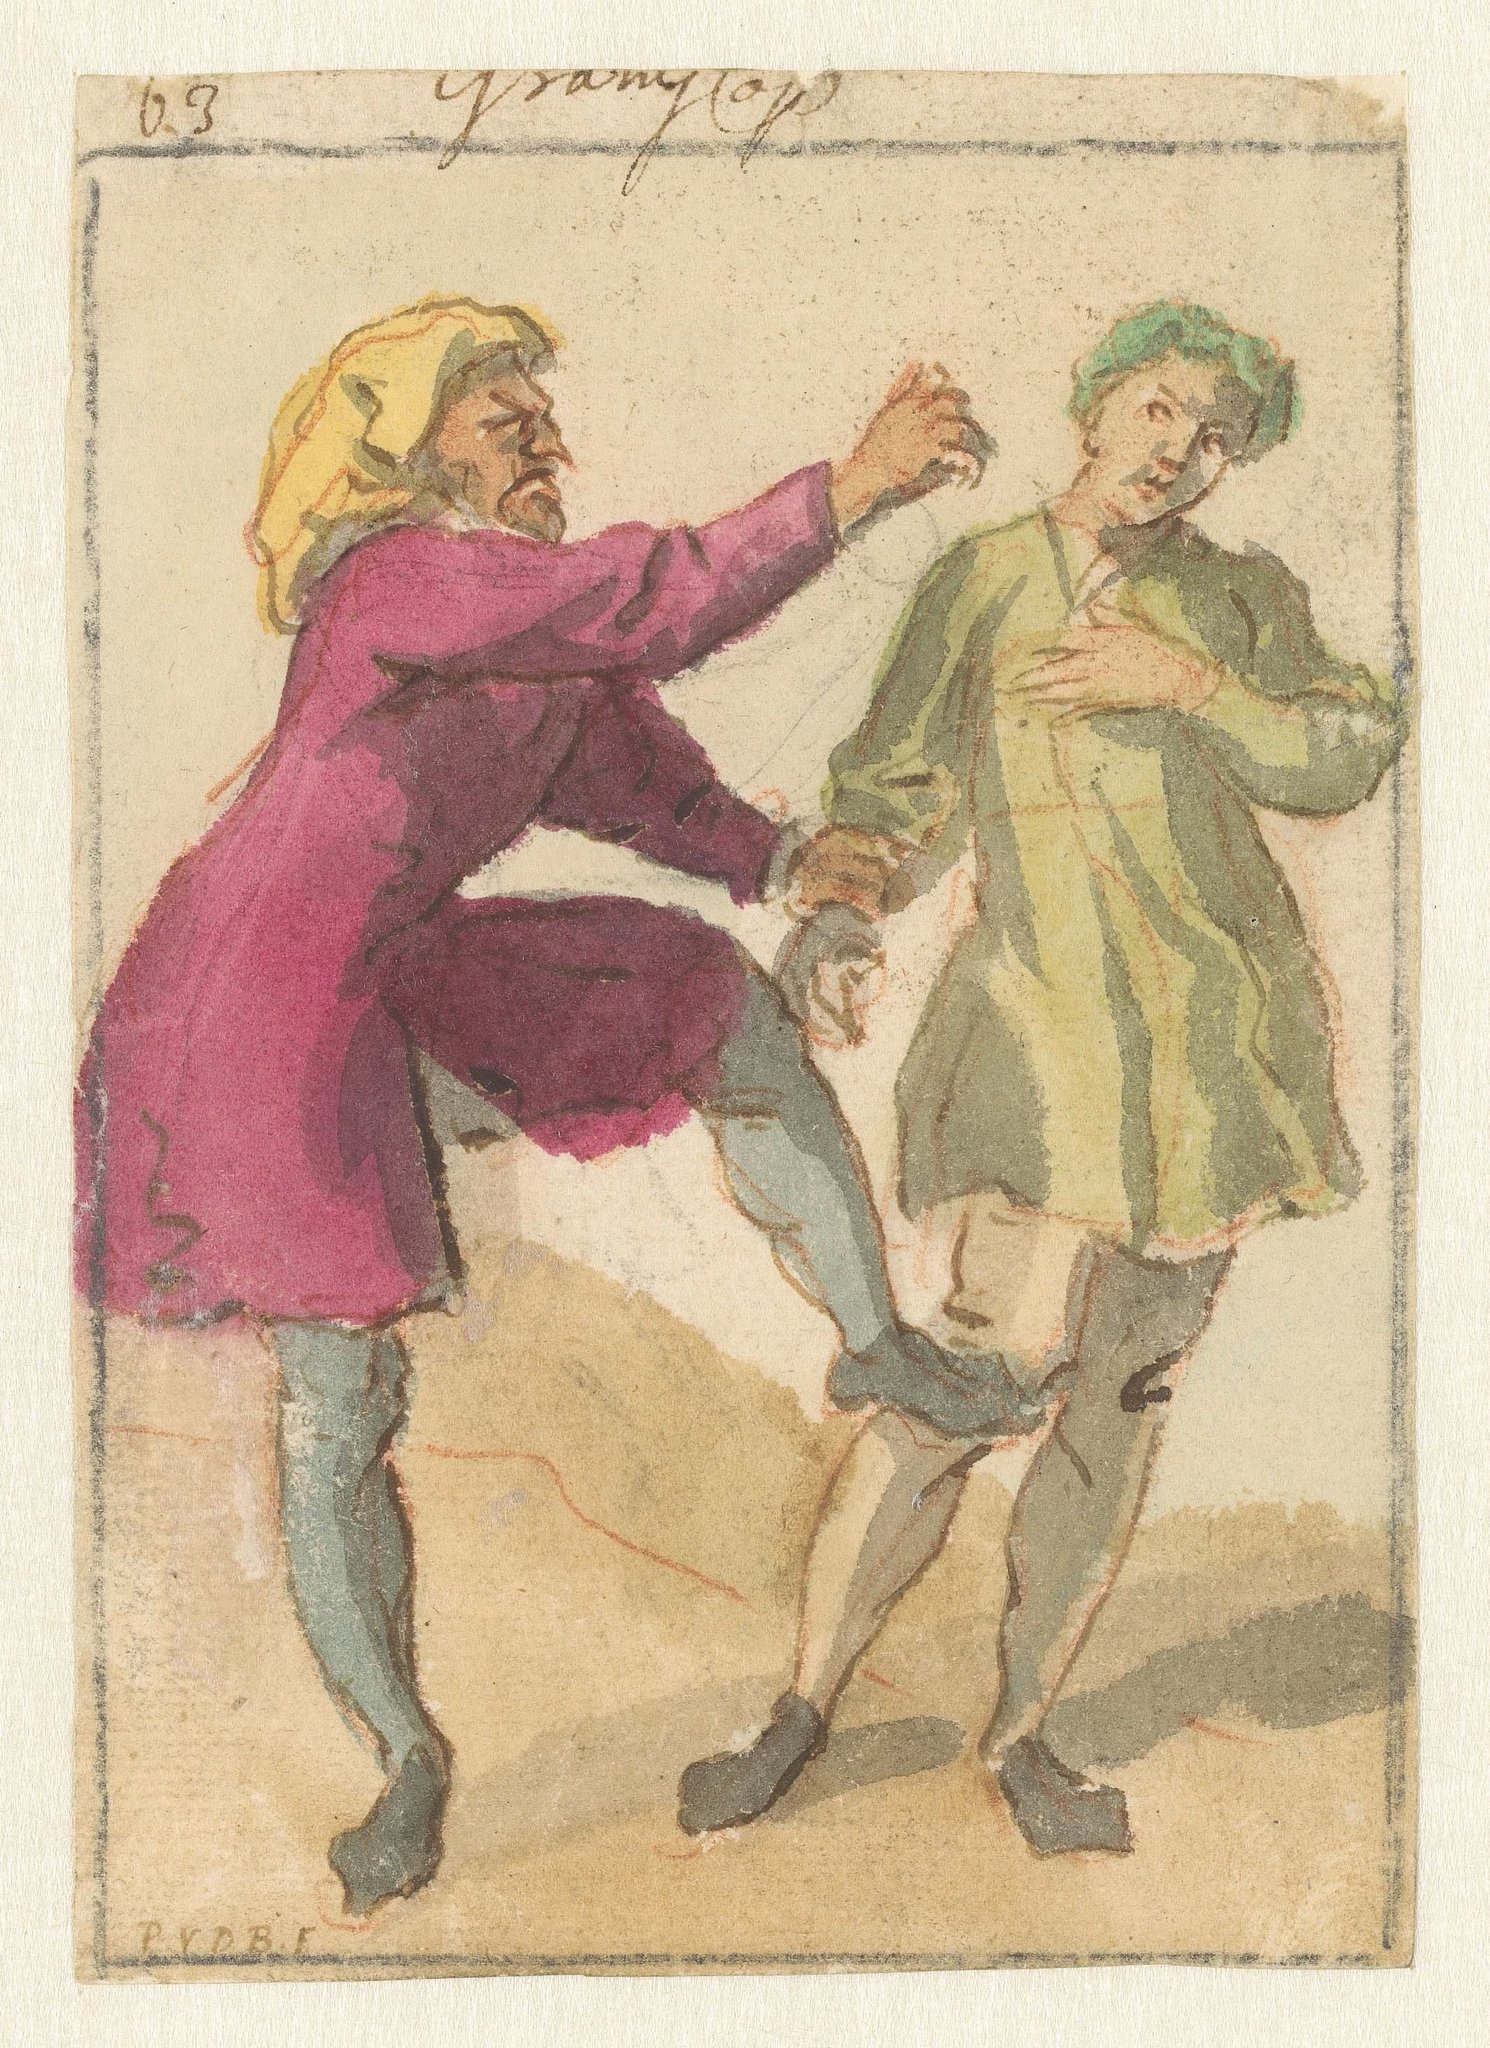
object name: drawing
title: Uitbeeldingen van karakters, eigenschappen, deugden en ondeugden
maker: pieter van den berge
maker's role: draughtsman, print maker, printer, publisher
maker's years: 1659-1737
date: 1675-1737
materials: chalk, ink, paper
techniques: brush, pen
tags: anger; 'ira' (ripa) ~ personification of one of the seven deadly sins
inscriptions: number: ‘63’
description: Rechts een man met de hand op de borst. Hij wordt bij de arm gegrepen door een man, die hem met de linkervoet op de rechterknie trapt.